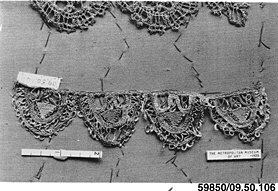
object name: strip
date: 1601-1700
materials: metal thread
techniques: lace